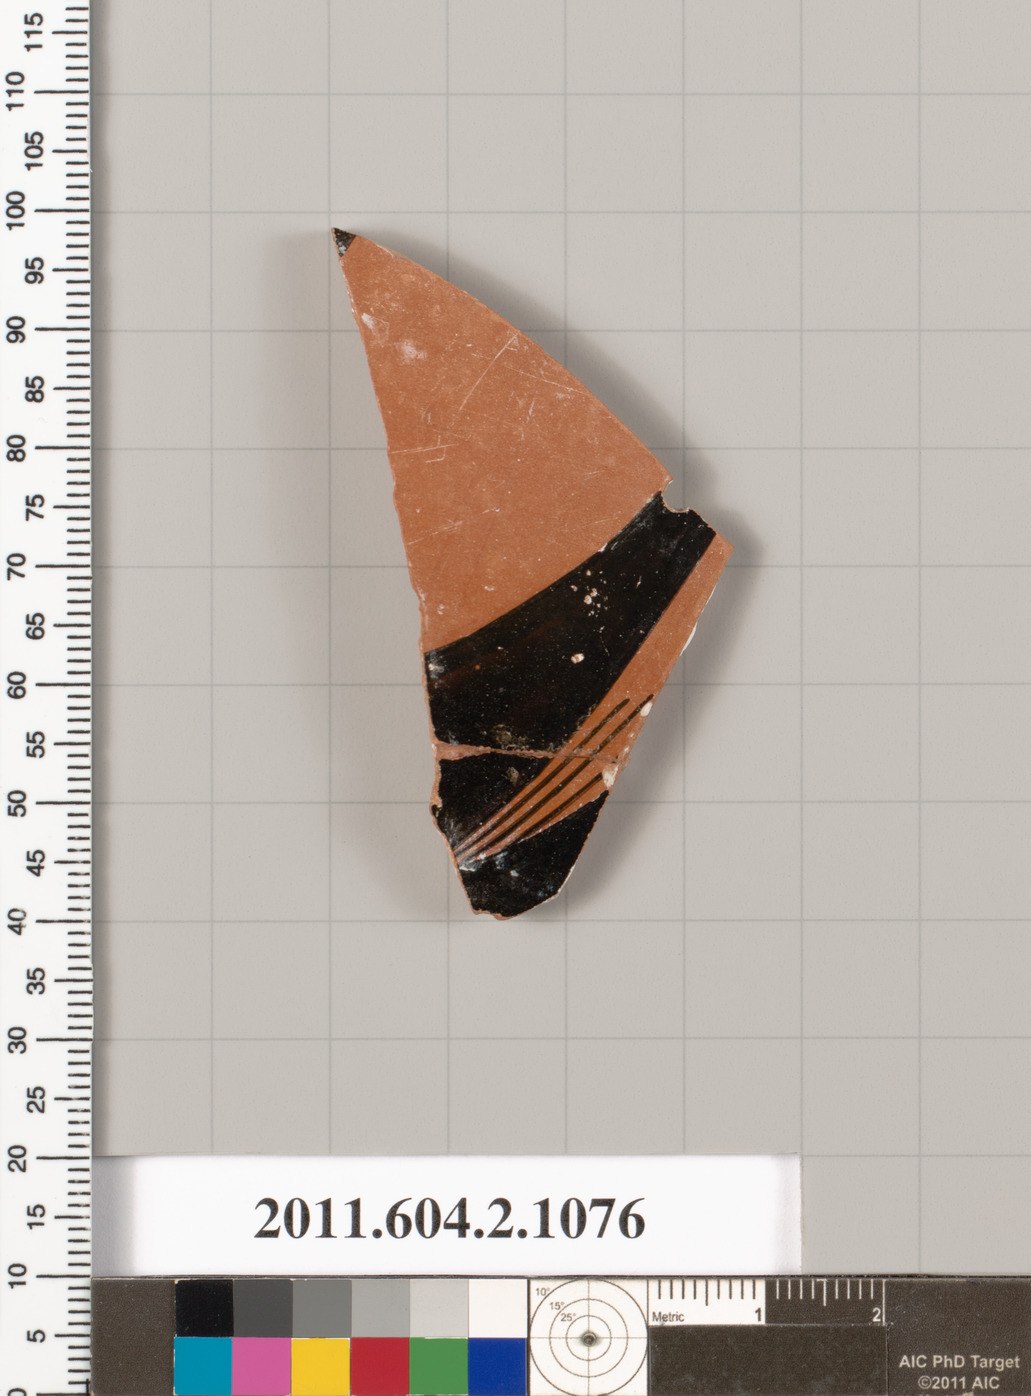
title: Terracotta fragment of a closed shape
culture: greek, attic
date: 475-451 BCE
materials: terracotta